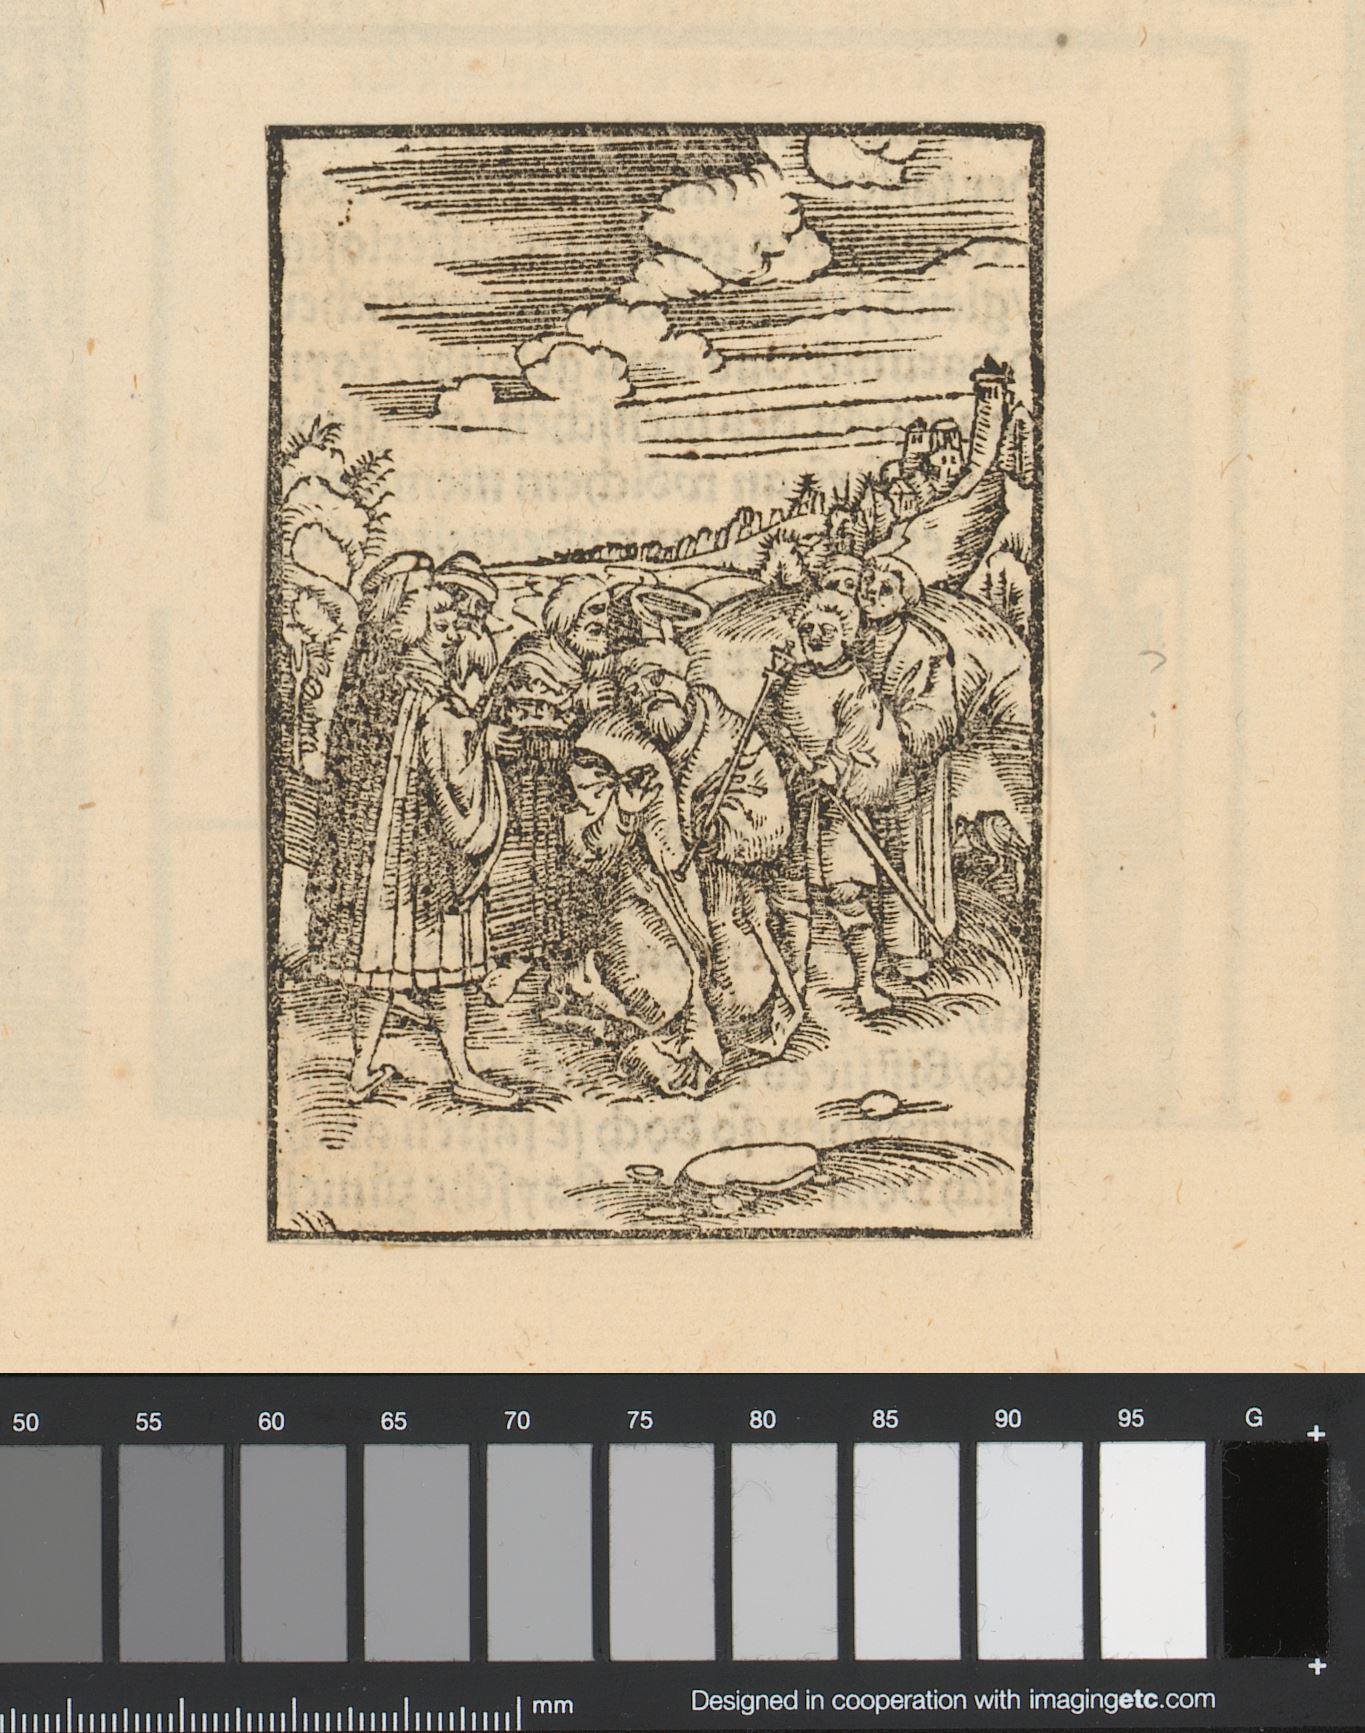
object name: album leaf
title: Doop van een koning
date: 1514-1532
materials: paper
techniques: letterpress printing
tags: solemn baptism (by bishop or priest) - qq - baptism in the open air